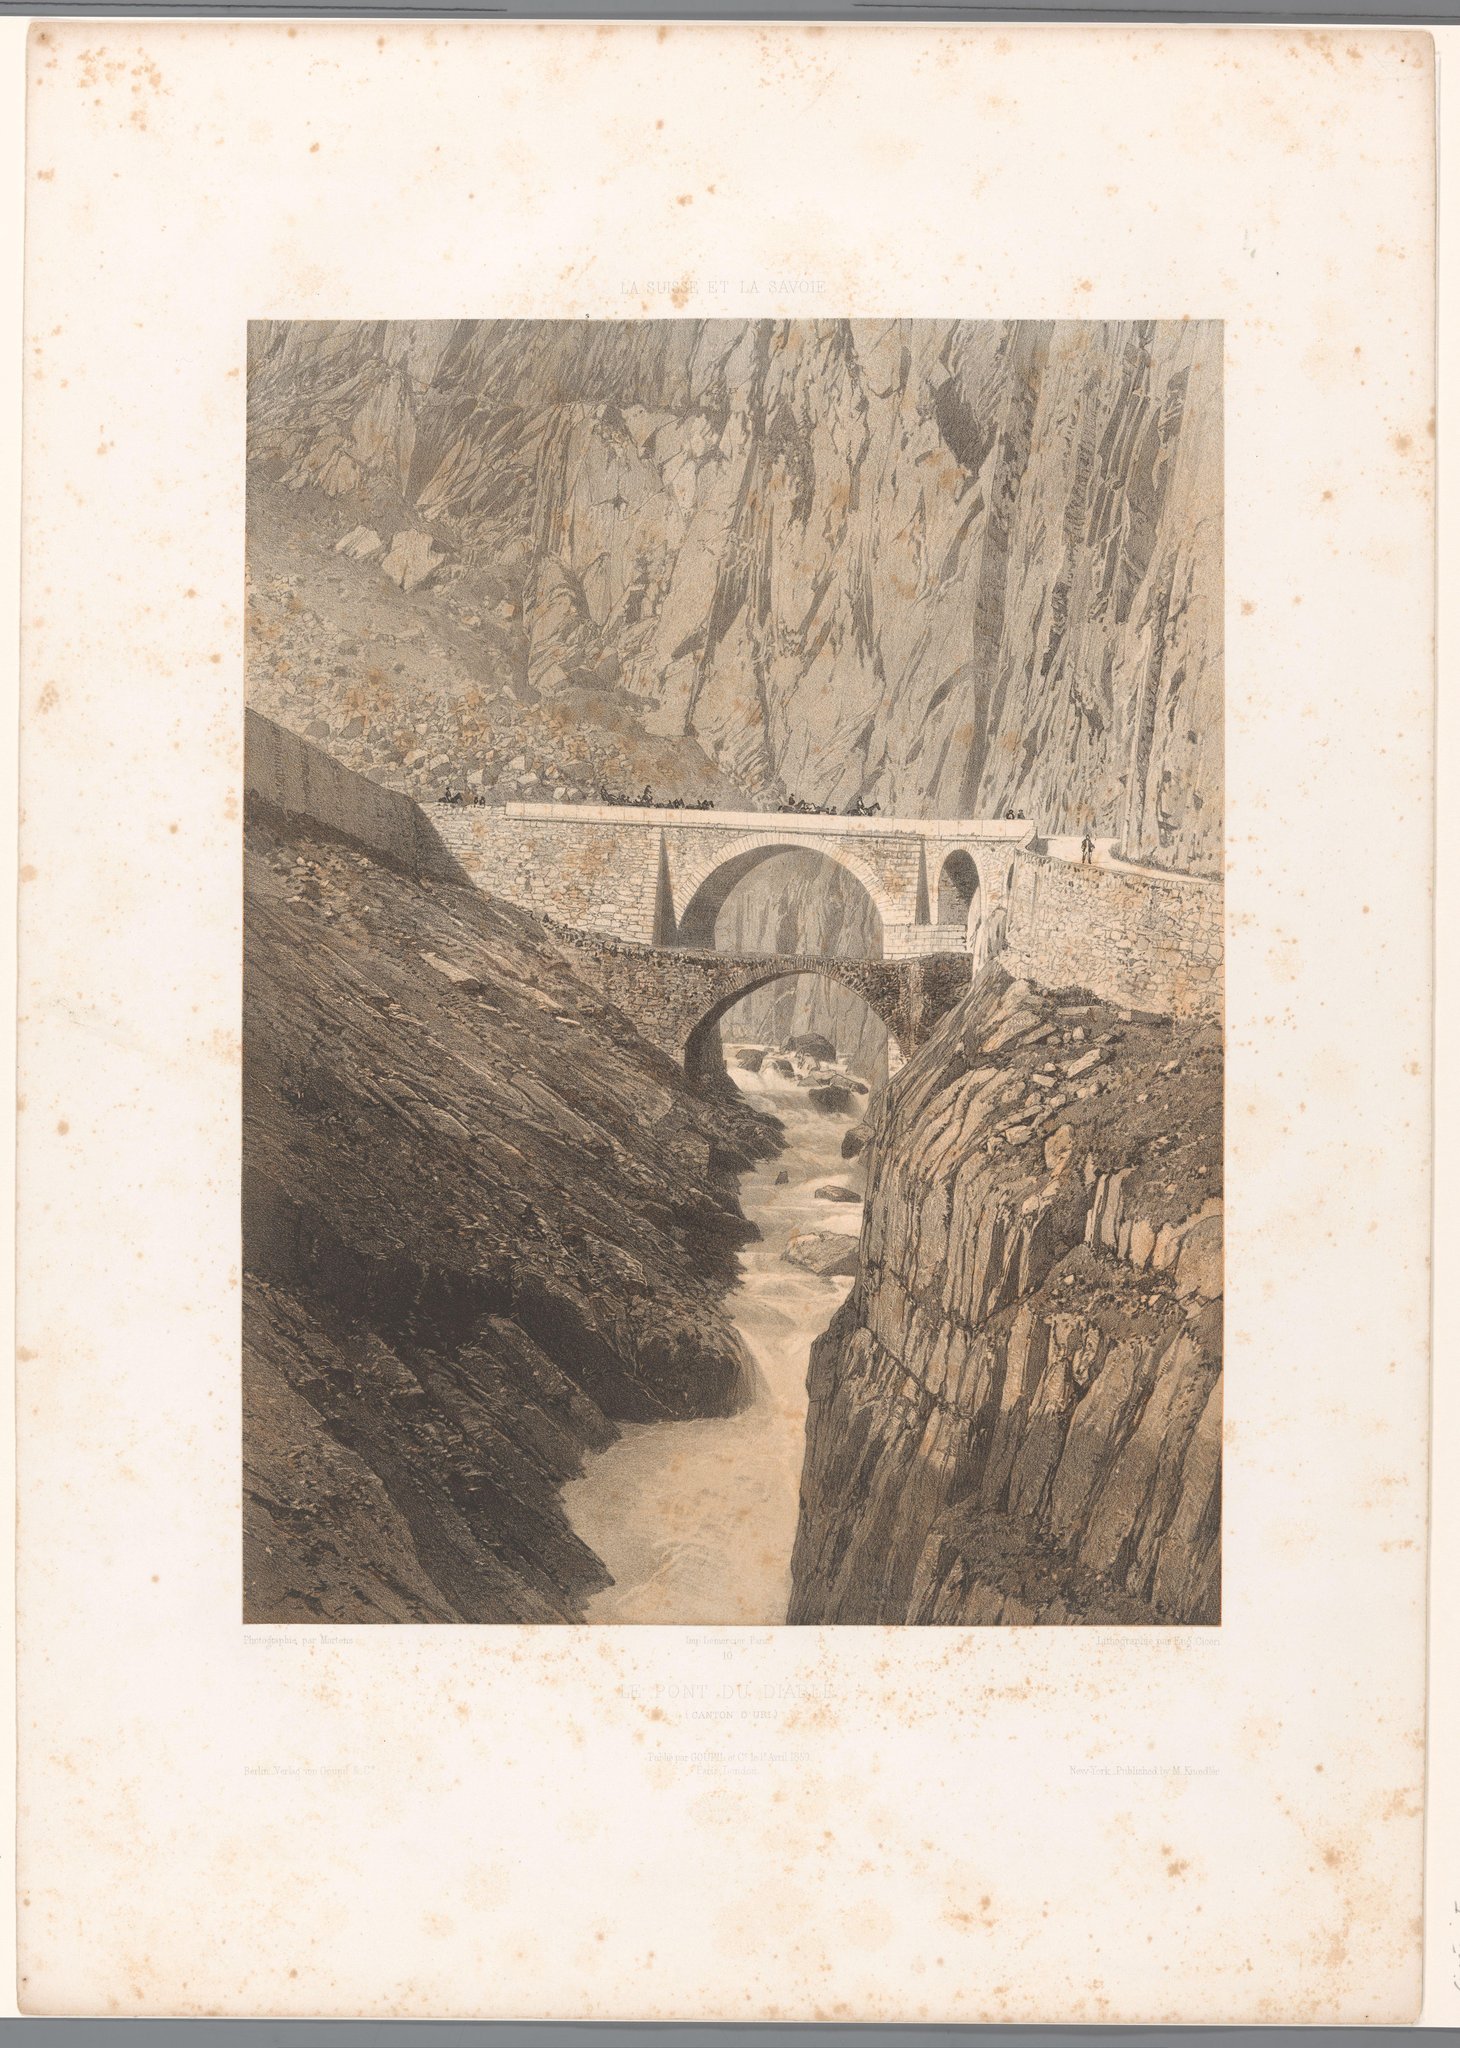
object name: print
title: Le pont du diable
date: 1859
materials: paper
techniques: lithograph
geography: new york city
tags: landscape with bridge, viaduct or aqueduct, ravine, chasm, abyss, canyon, brook, bridge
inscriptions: check stamp: Lugt 1090